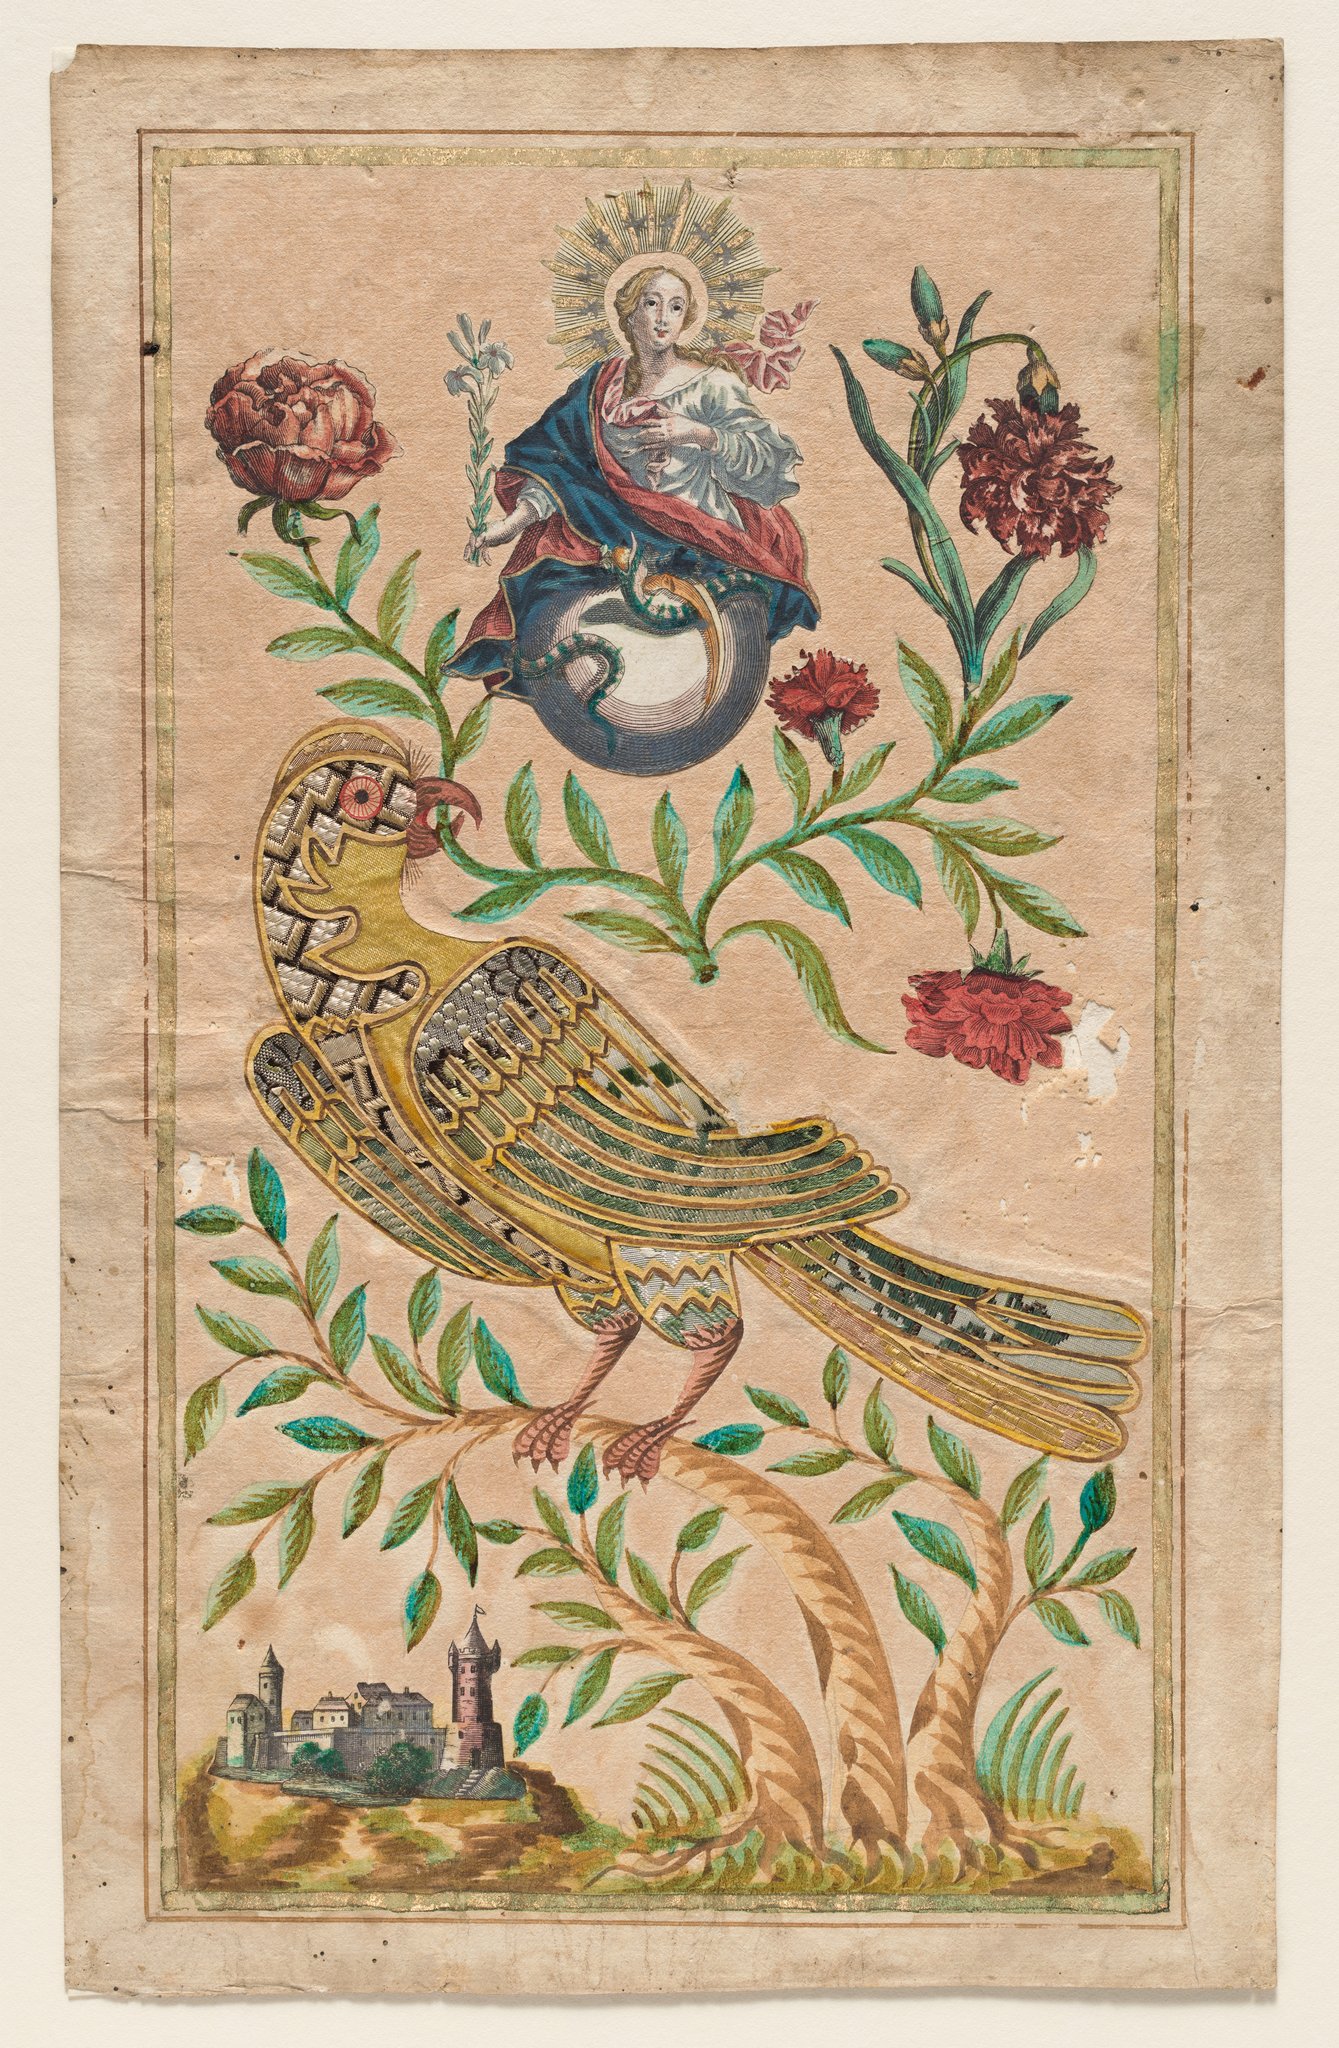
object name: cut paper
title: Virgin with a Lily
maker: anonymous, german, 18th century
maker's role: artist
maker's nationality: german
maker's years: 1700-1800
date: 1701-1800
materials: paint, paper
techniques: engraving, hand coloring